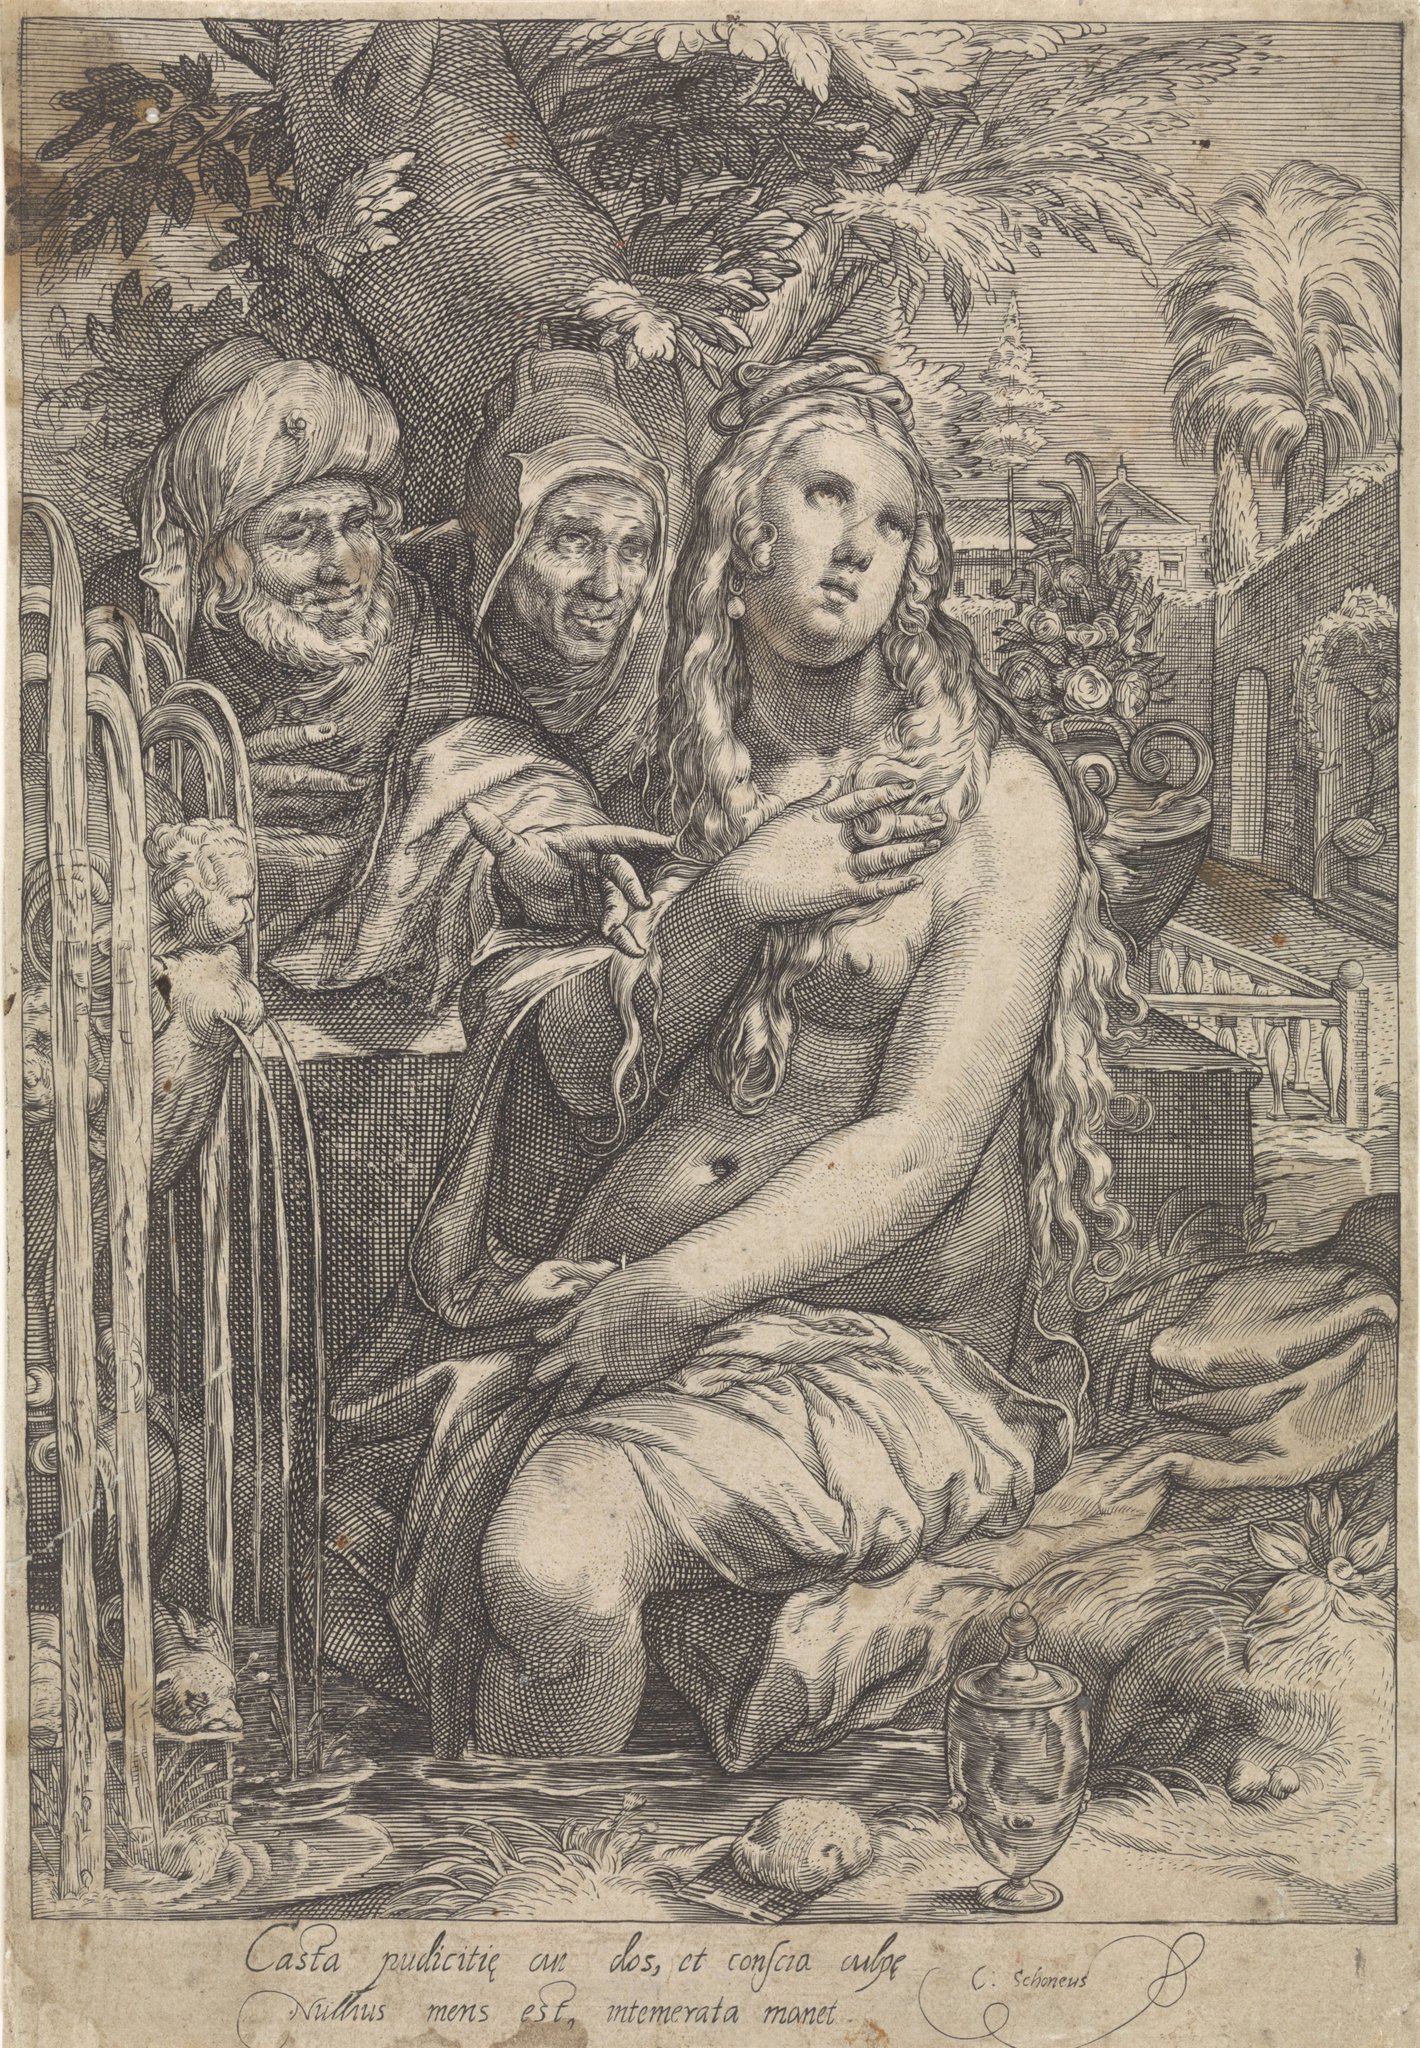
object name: print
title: Susanna en de ouderlingen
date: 1575-1657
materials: paper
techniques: engraving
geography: northern netherlands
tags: the elders spying upon susanna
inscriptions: signature: ‘C. Schoneus’, caption: ‘Casta pudicitie cui dos, et conscia culpe / Nullius mens est, intemerata manet.’, collector's mark: Lugt 2228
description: De half-naakte Susanna zit aan de rand van het bad. Twee ouderlingen begluren haar tijdens het baden en spreken haar aan. De prent heeft een Latijns onderschrift.